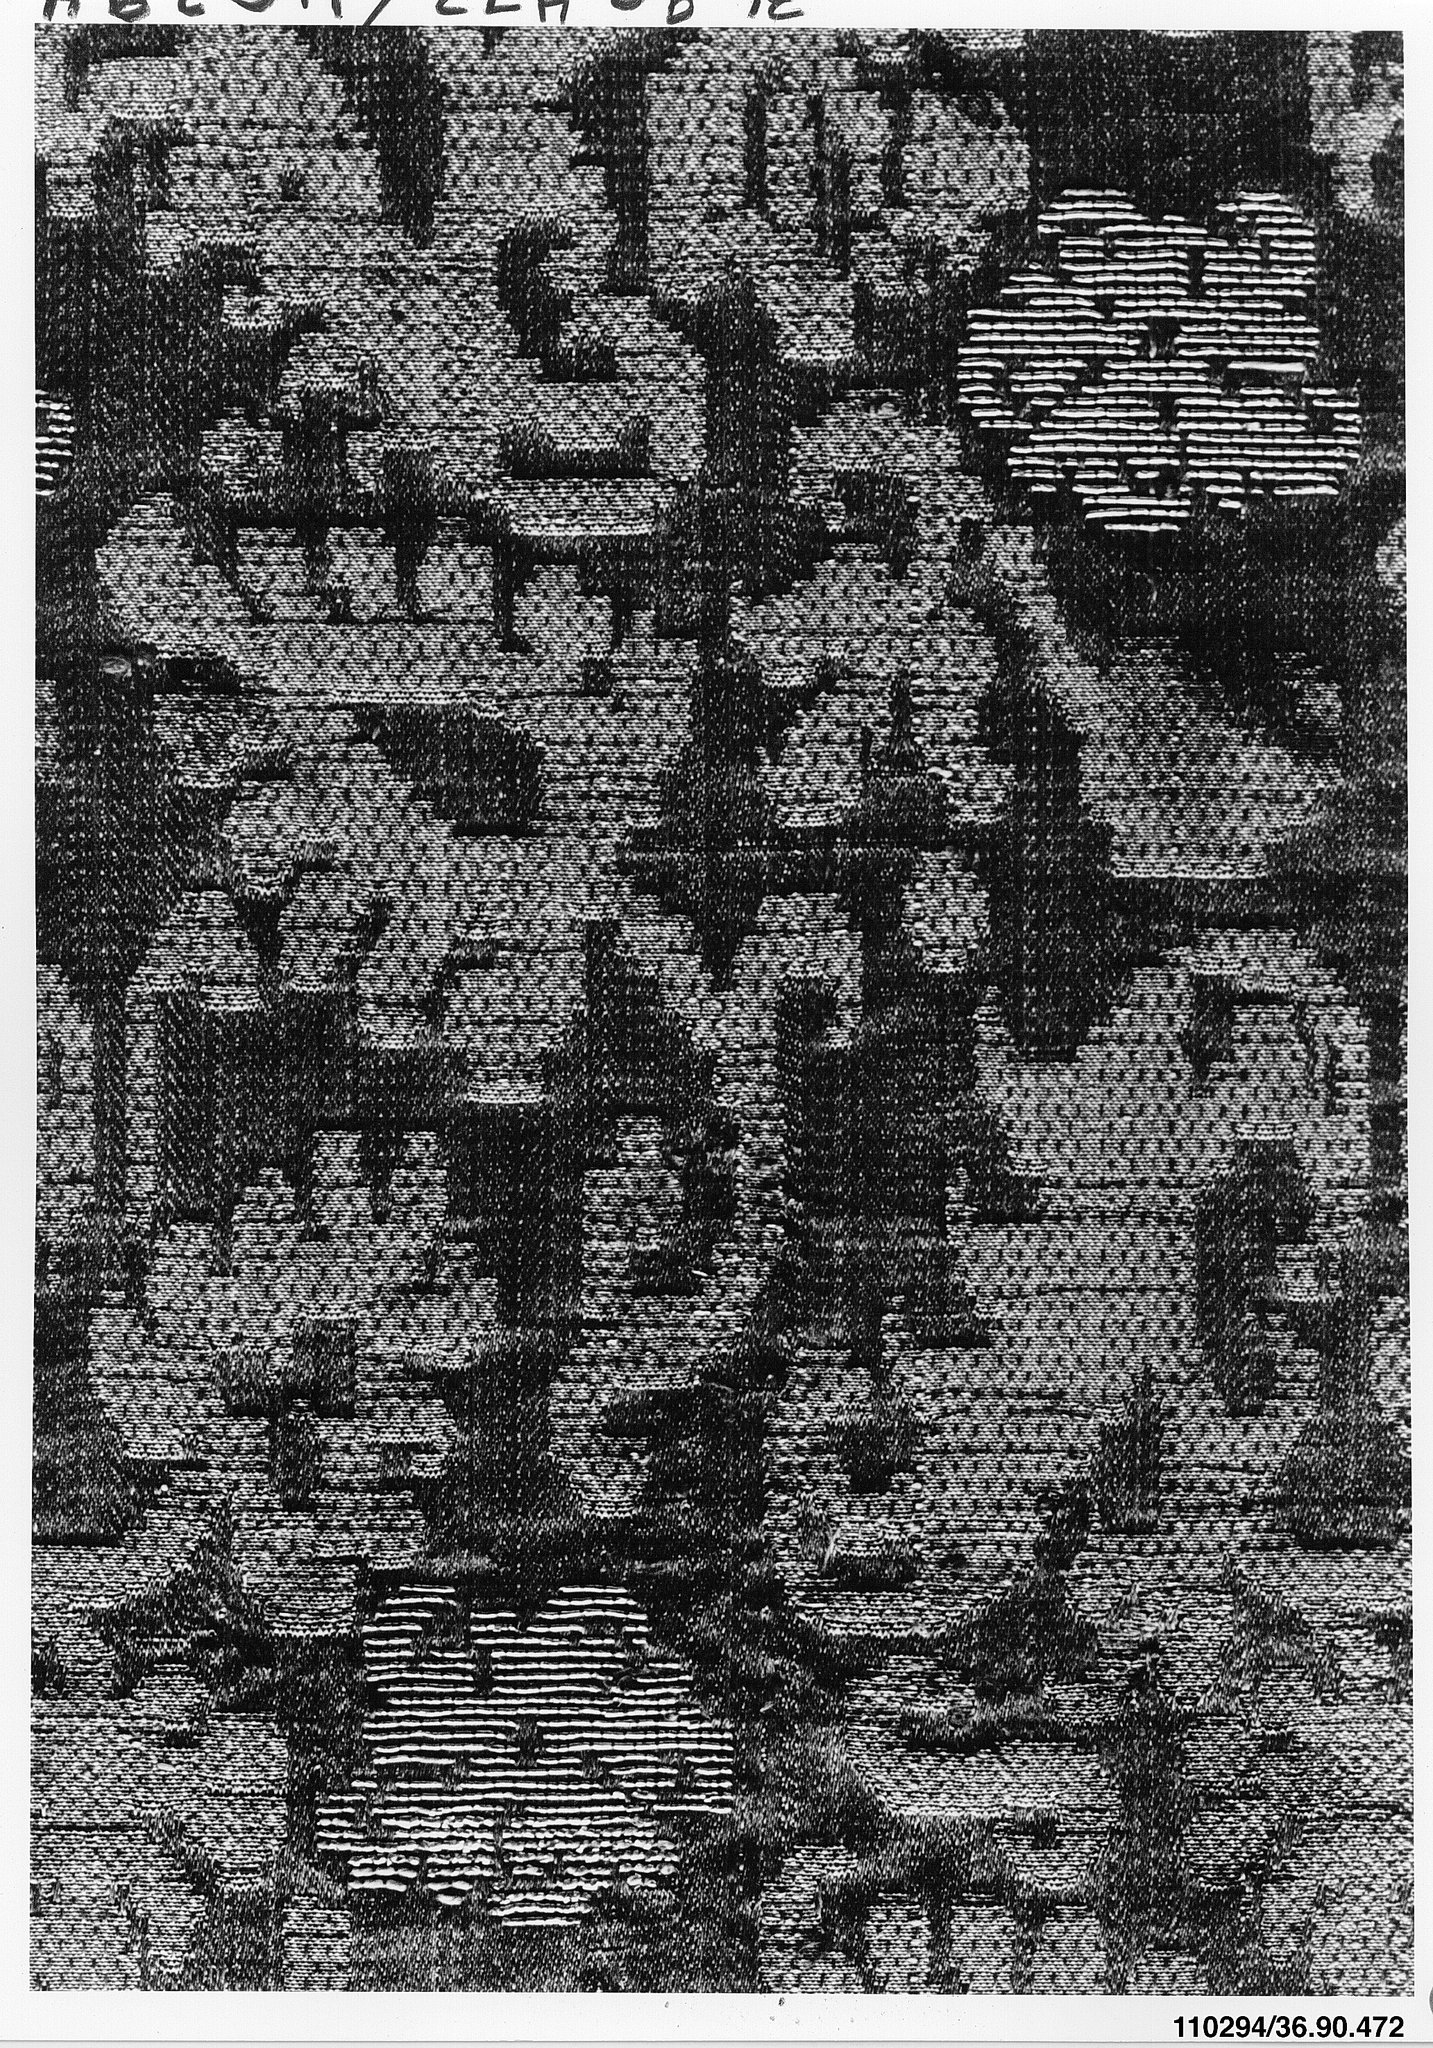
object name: piece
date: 1501-1700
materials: metal thread, silk